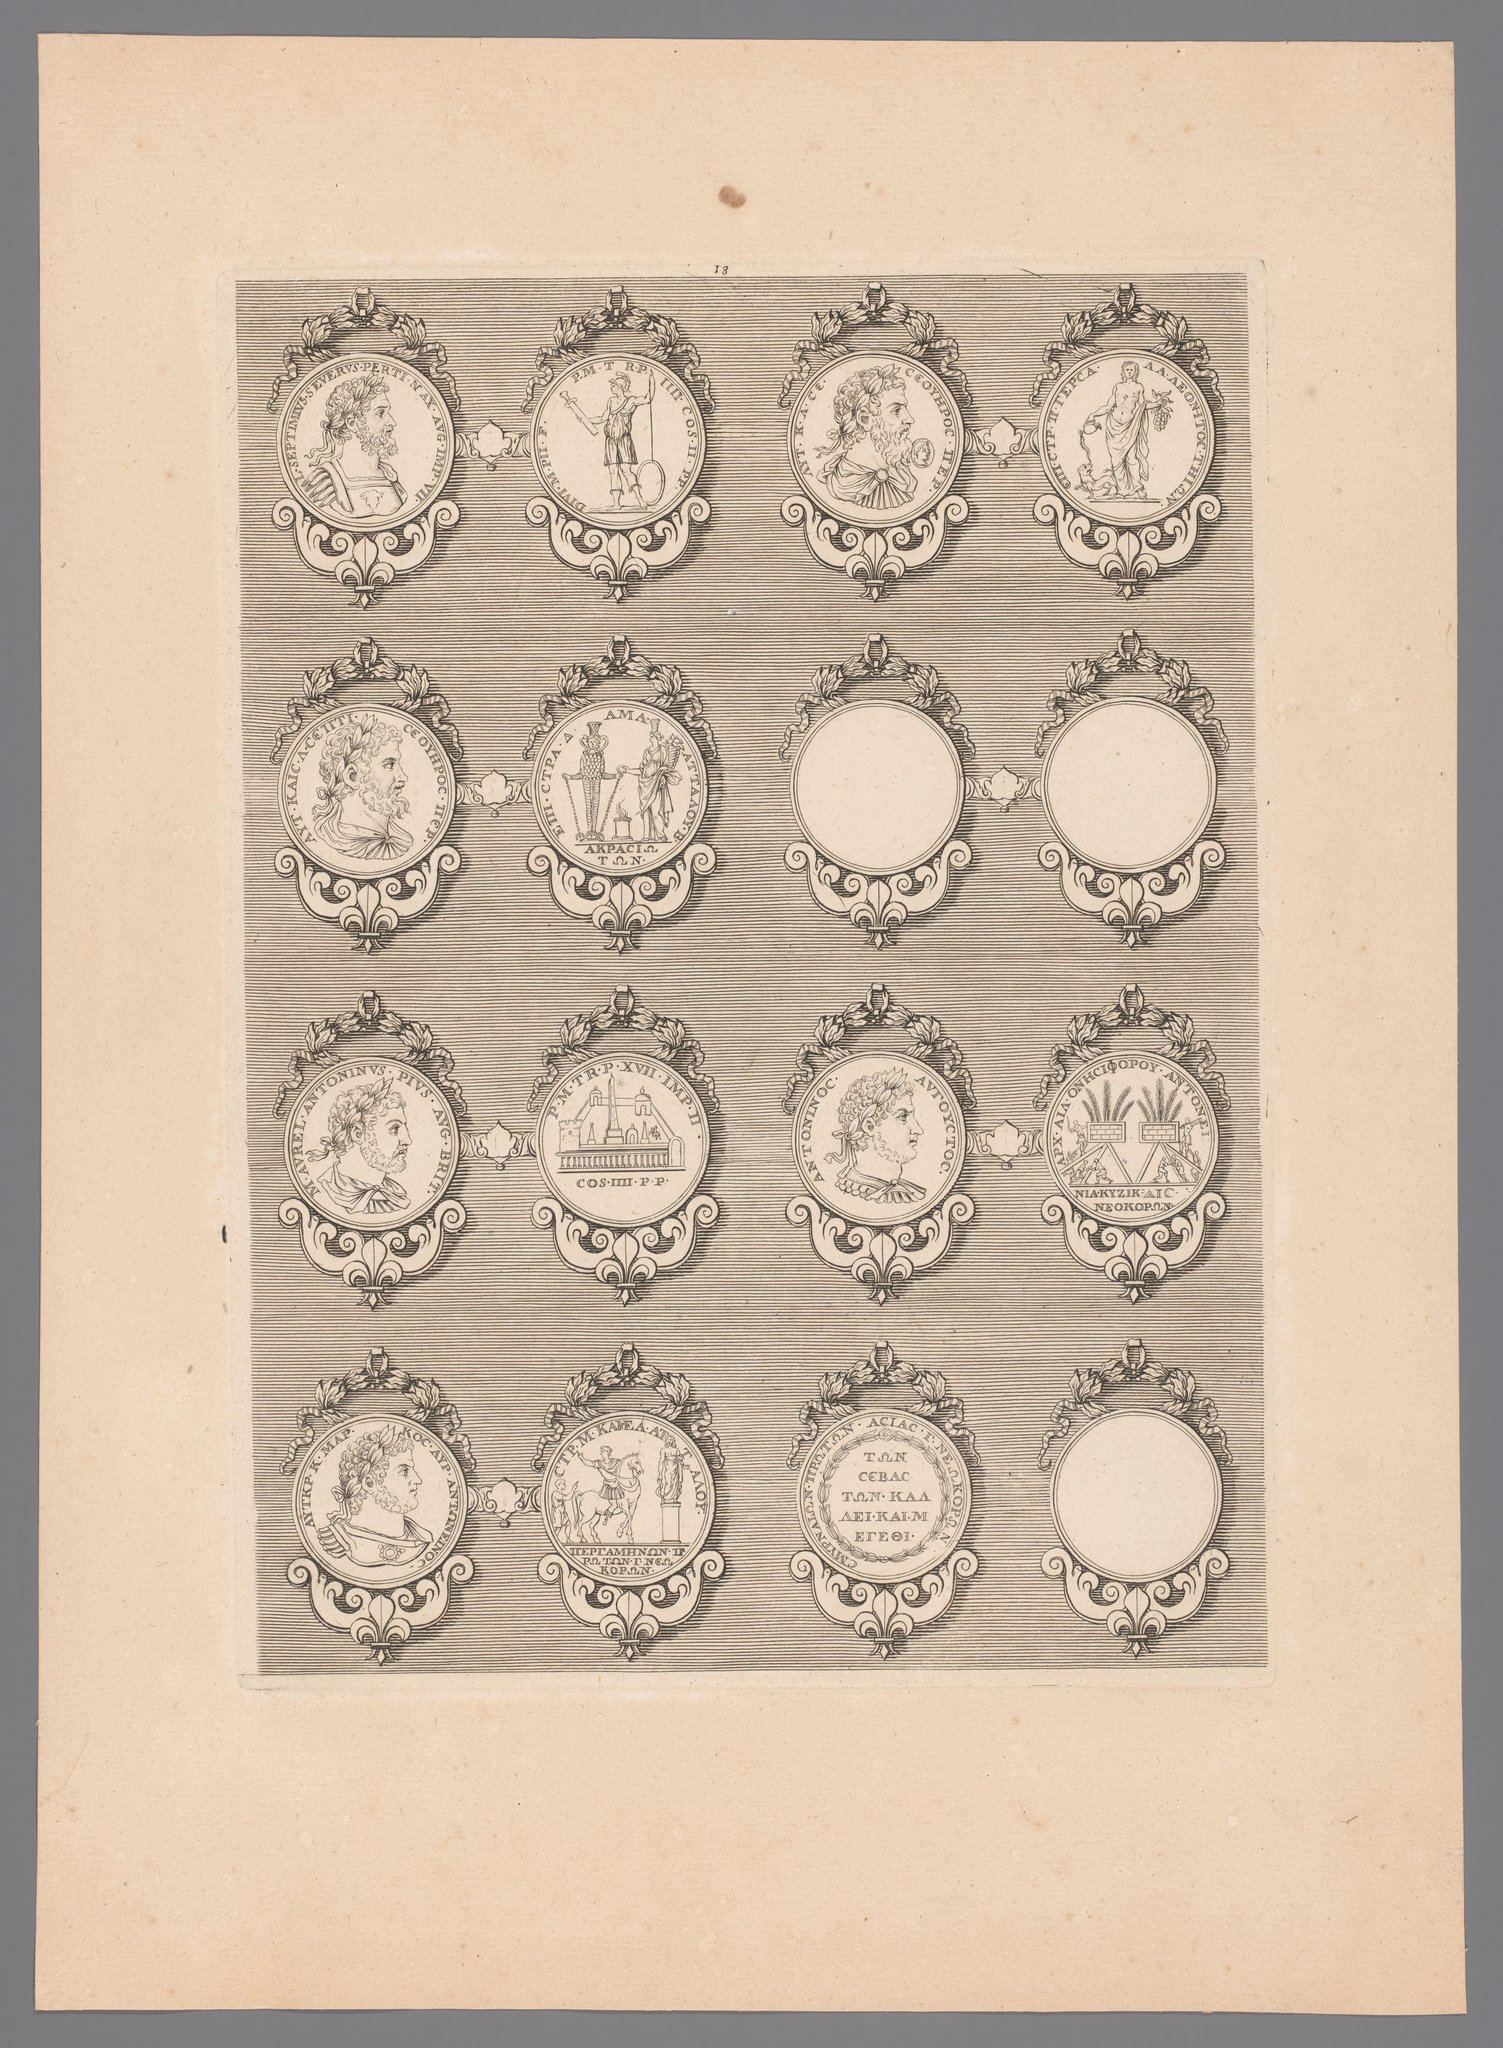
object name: print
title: Zestien penningen met versierde lijsten, waarvan drie blanco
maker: simon de la boissière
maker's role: print maker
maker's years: 1637-1682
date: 1647-1682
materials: paper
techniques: etching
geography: france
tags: medal (considered as a piece of sculpture, regardless of its specific function)